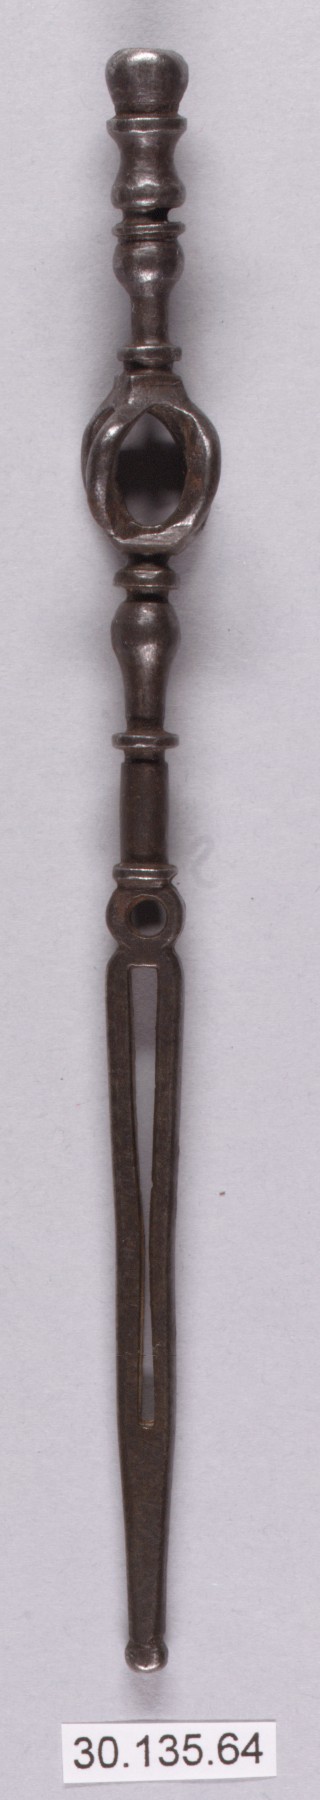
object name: bobbin or spindle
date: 1601-1700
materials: iron